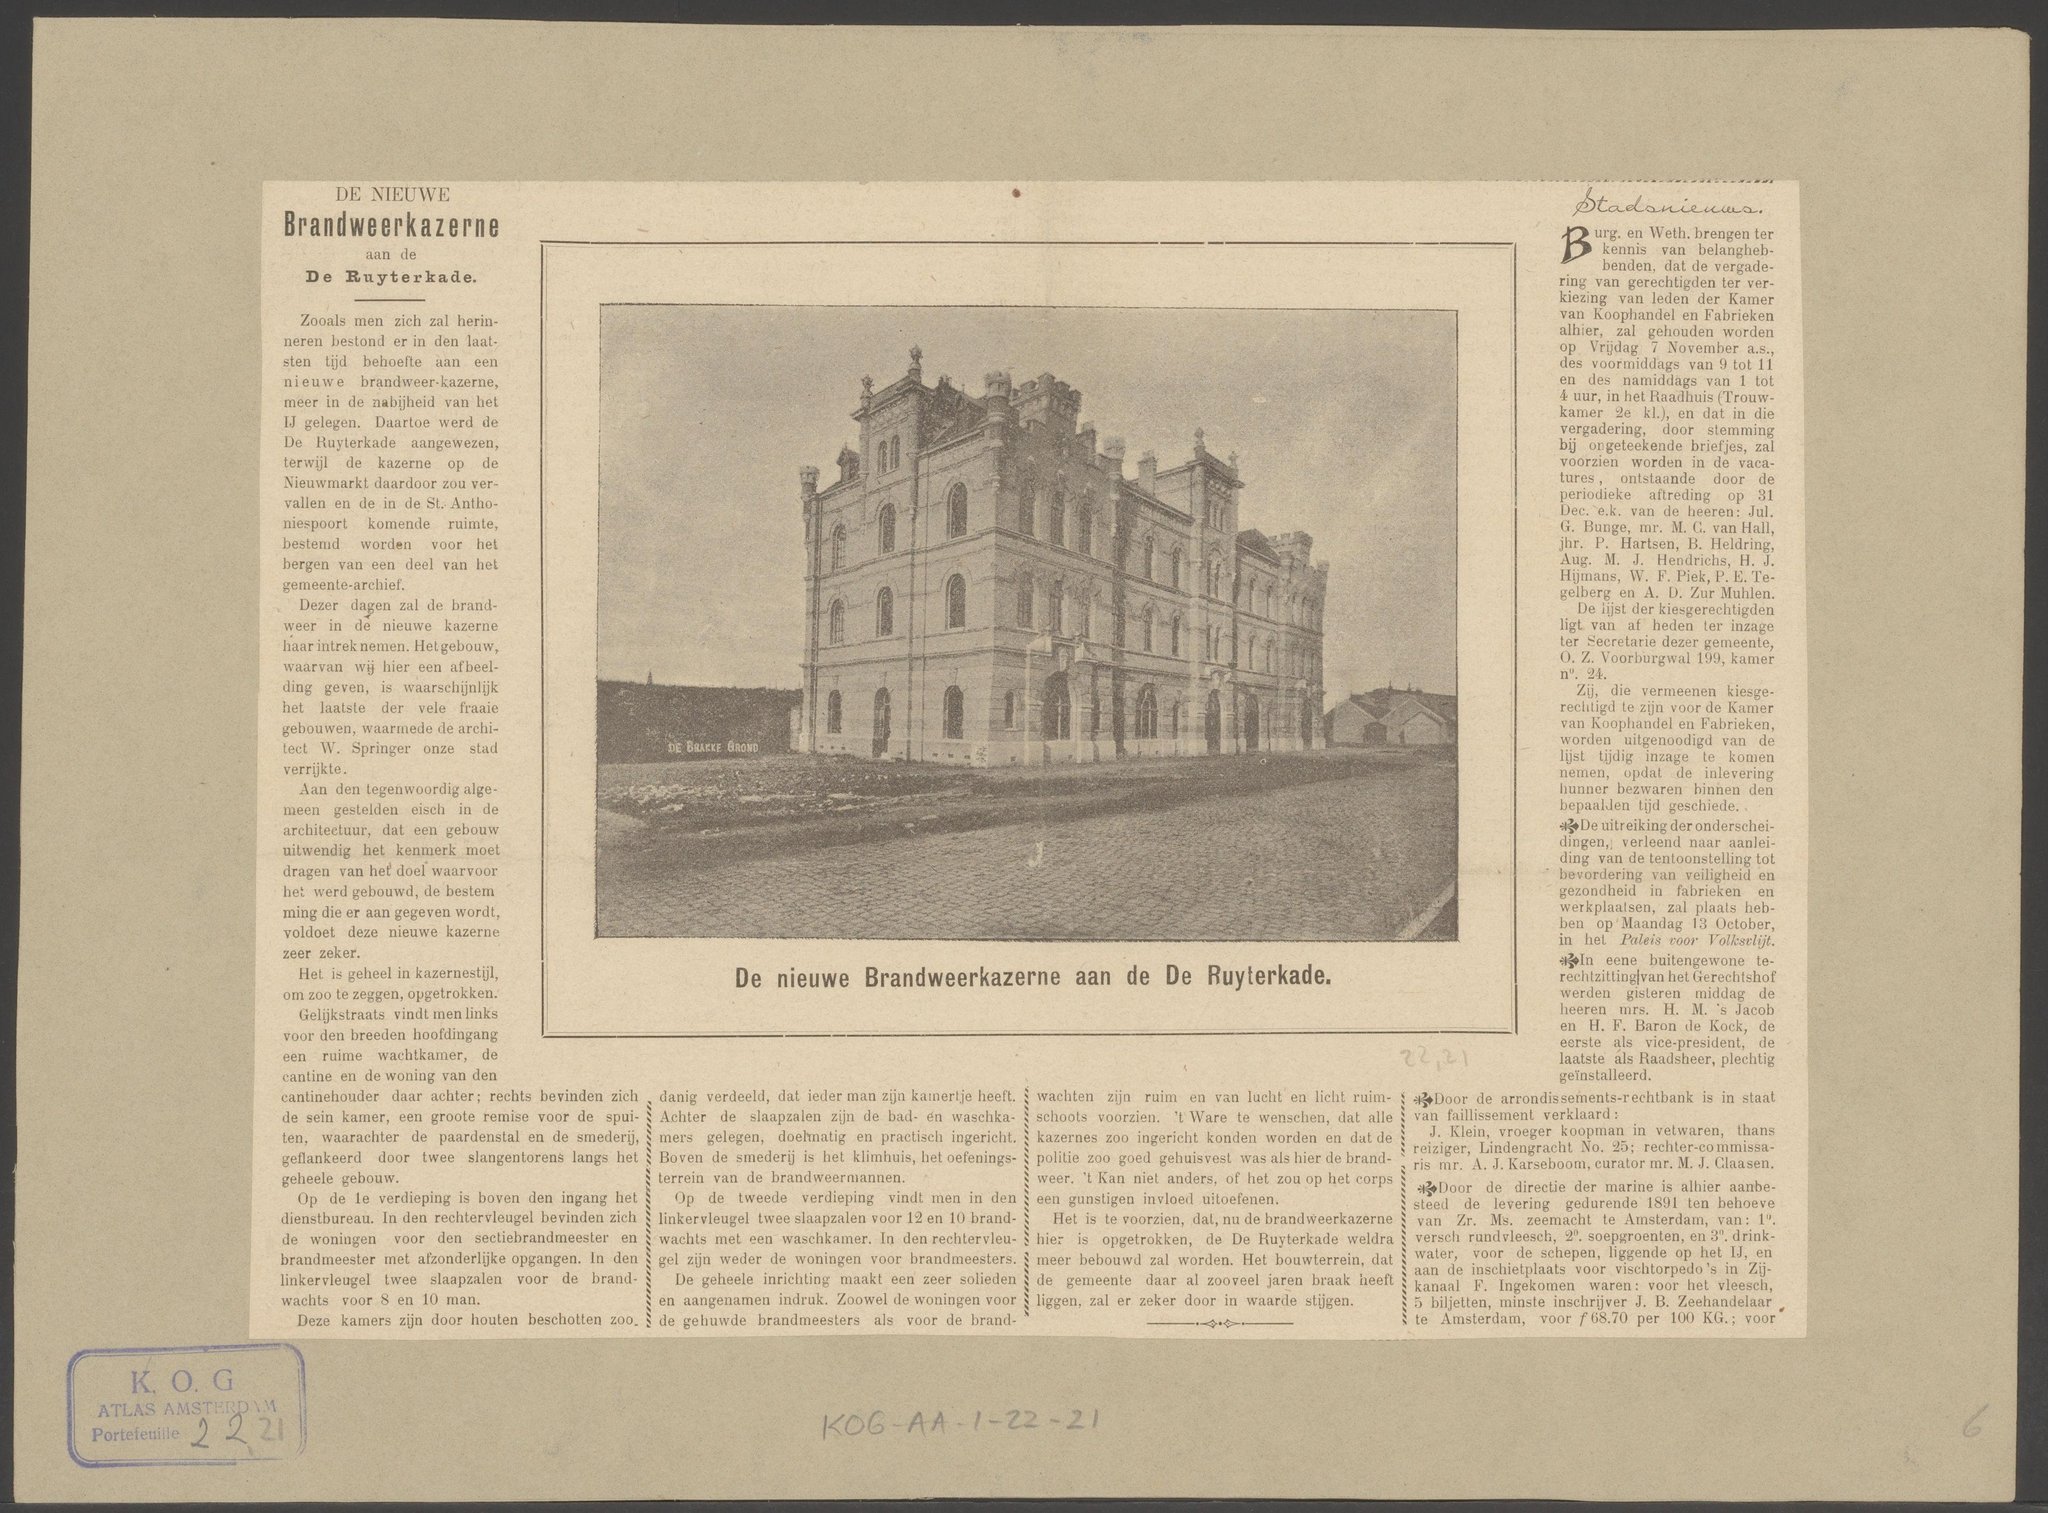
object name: photomechanical print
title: De nieuwe Brandweerkazerne aan de De Ruyterkade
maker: Anonymous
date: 1890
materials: paper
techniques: letterpress printing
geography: netherlands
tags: barracks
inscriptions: collector's mark: Lugt 1641b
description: Onderwerpsrubriek binnen de Atlas Amsterdam: Gemeentewerken: A. Brandweer.